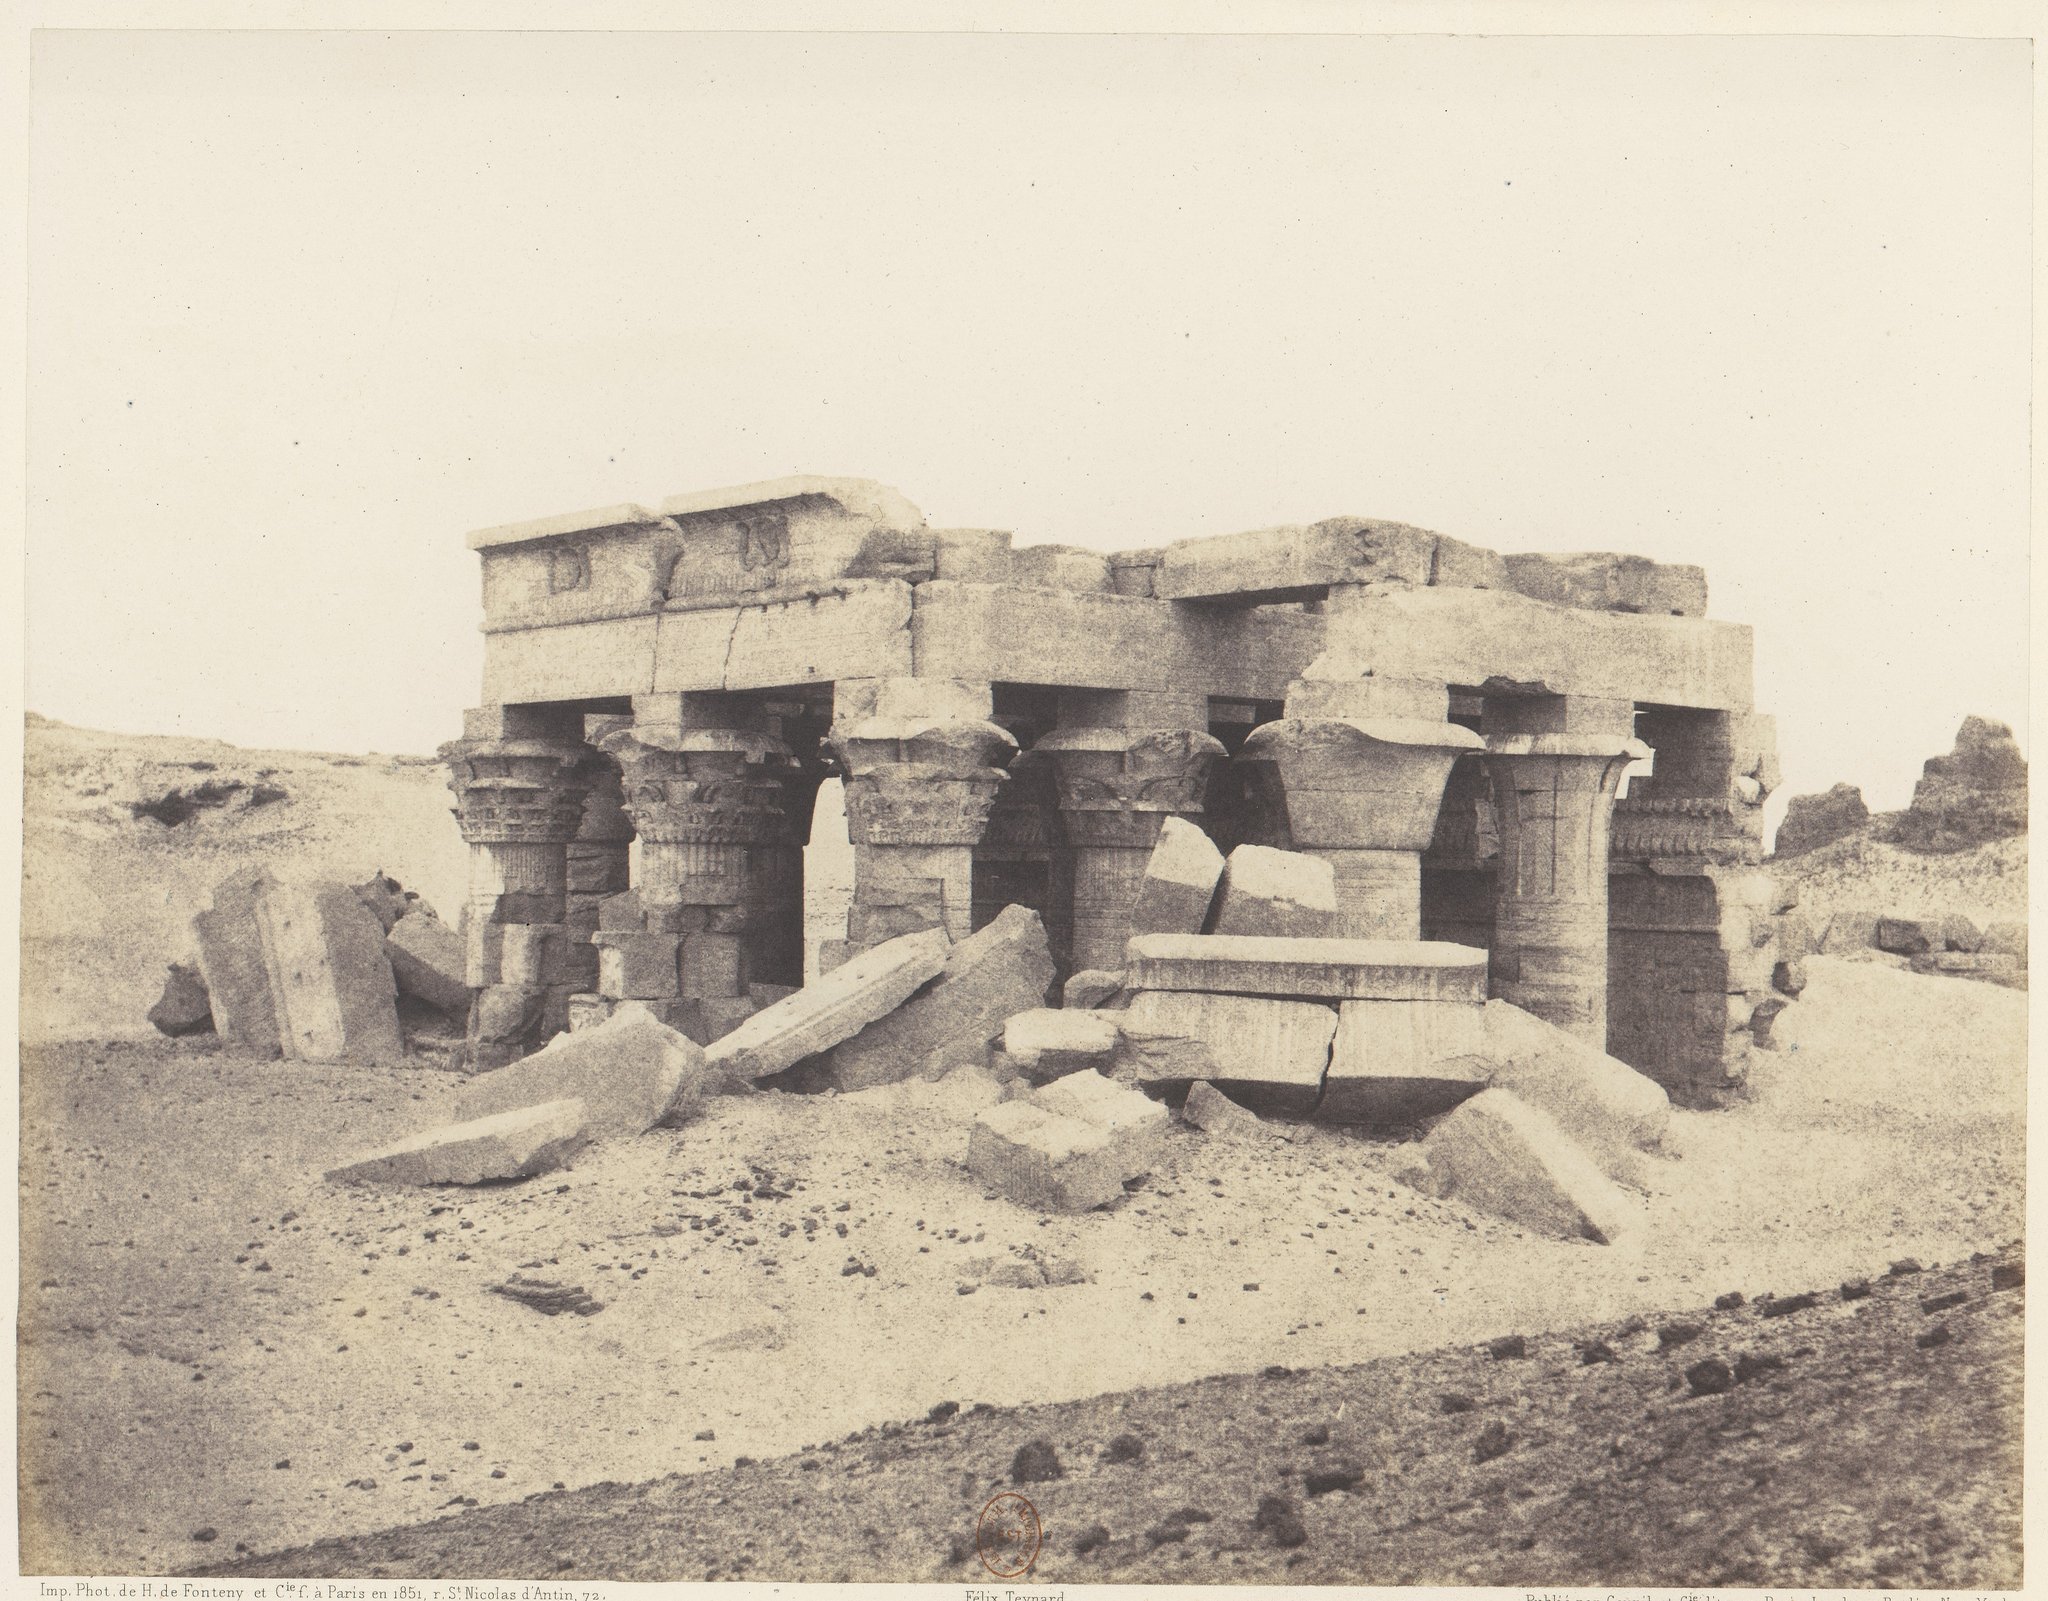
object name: photograph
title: Kôm-Ombou (Ombos), Vue Générale des Ruines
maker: félix teynard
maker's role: artist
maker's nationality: french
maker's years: 1817-1892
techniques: paper negative, salted paper print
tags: architecture,ruins